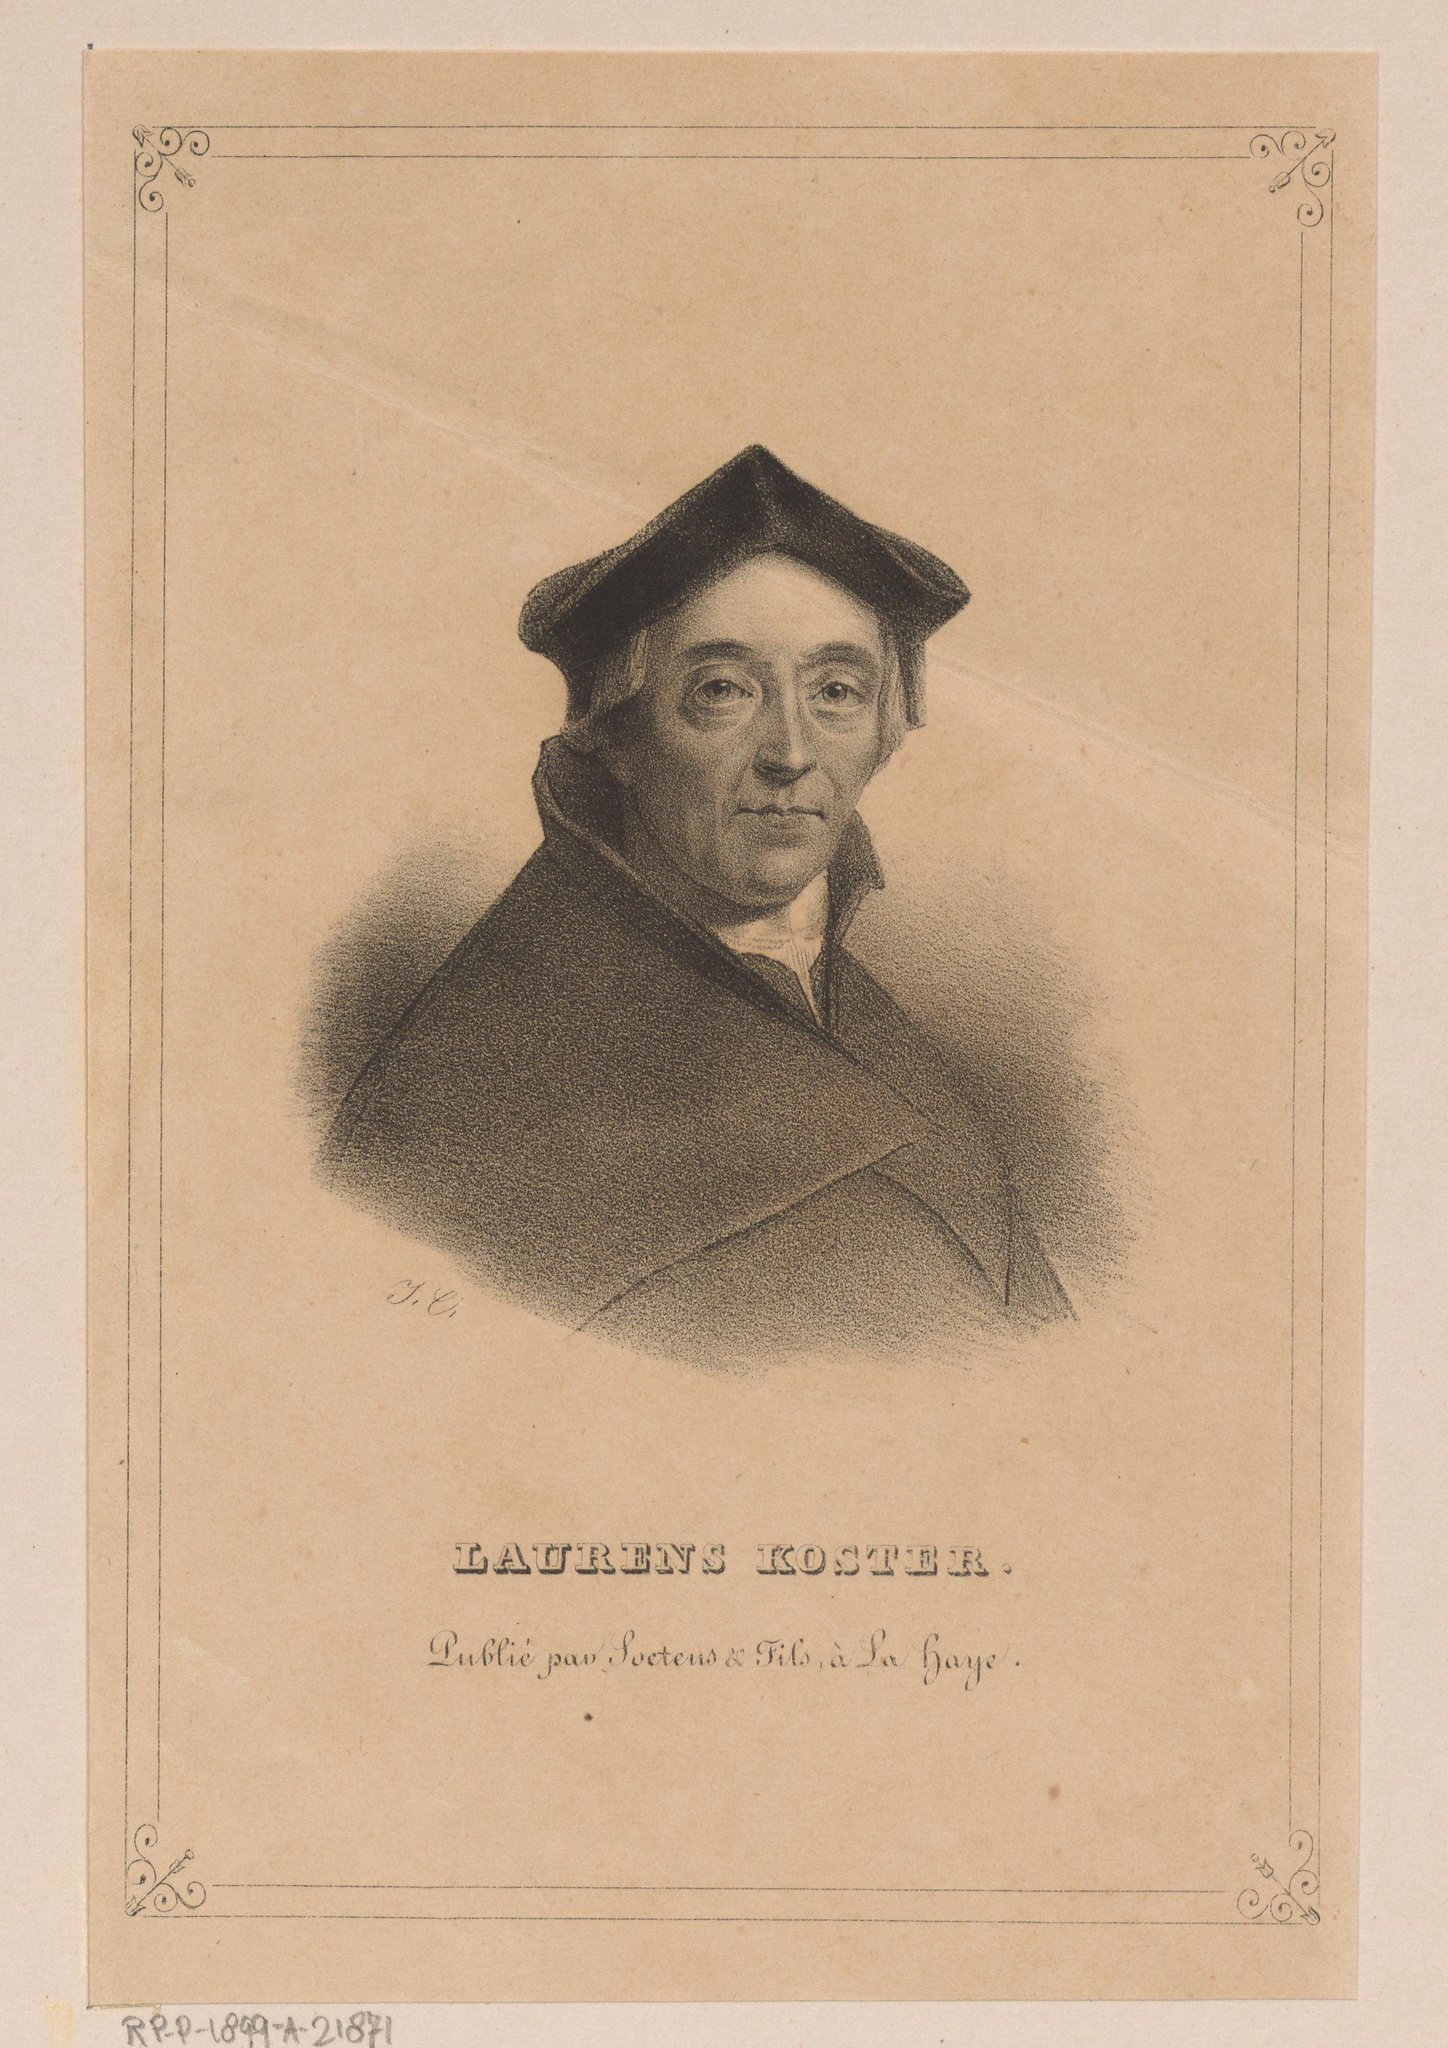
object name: print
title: Portret van Laurens Janszoon Coster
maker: j.b. clermans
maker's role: print maker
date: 1837-1840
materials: paper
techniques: lithograph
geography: the hague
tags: haarlem, historical persons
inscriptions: collector's mark: Lugt 2228, signature: ‘J.C.’